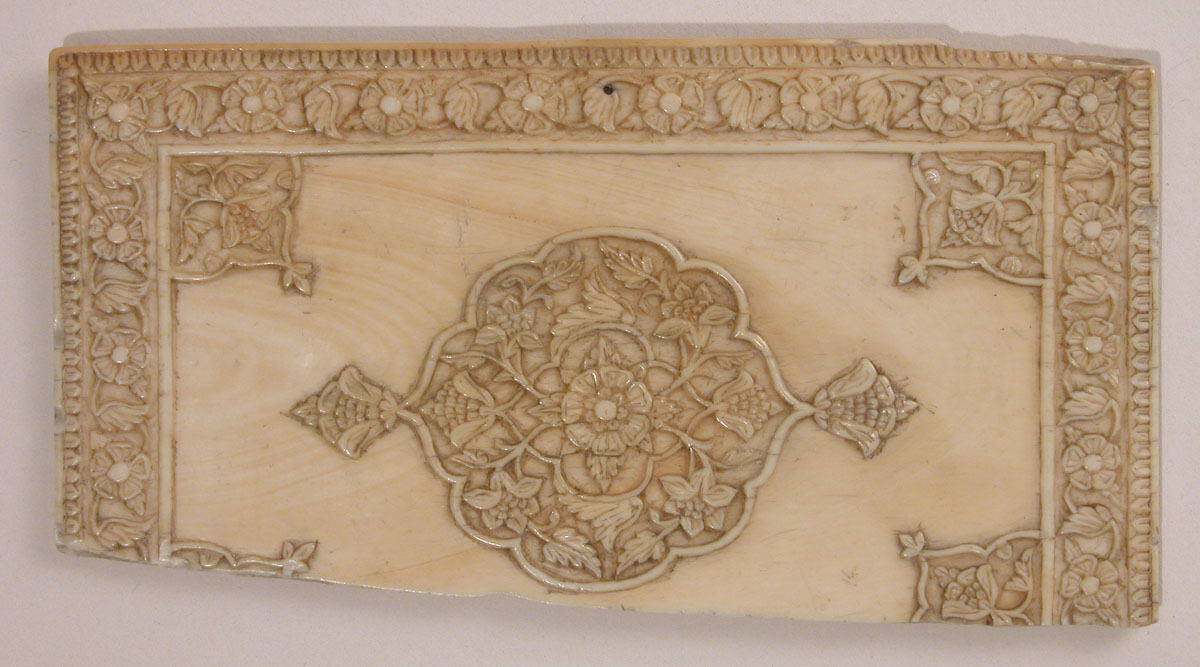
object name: fragment of a box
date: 1601-1700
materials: ivory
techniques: carving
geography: india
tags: flowers,leaves